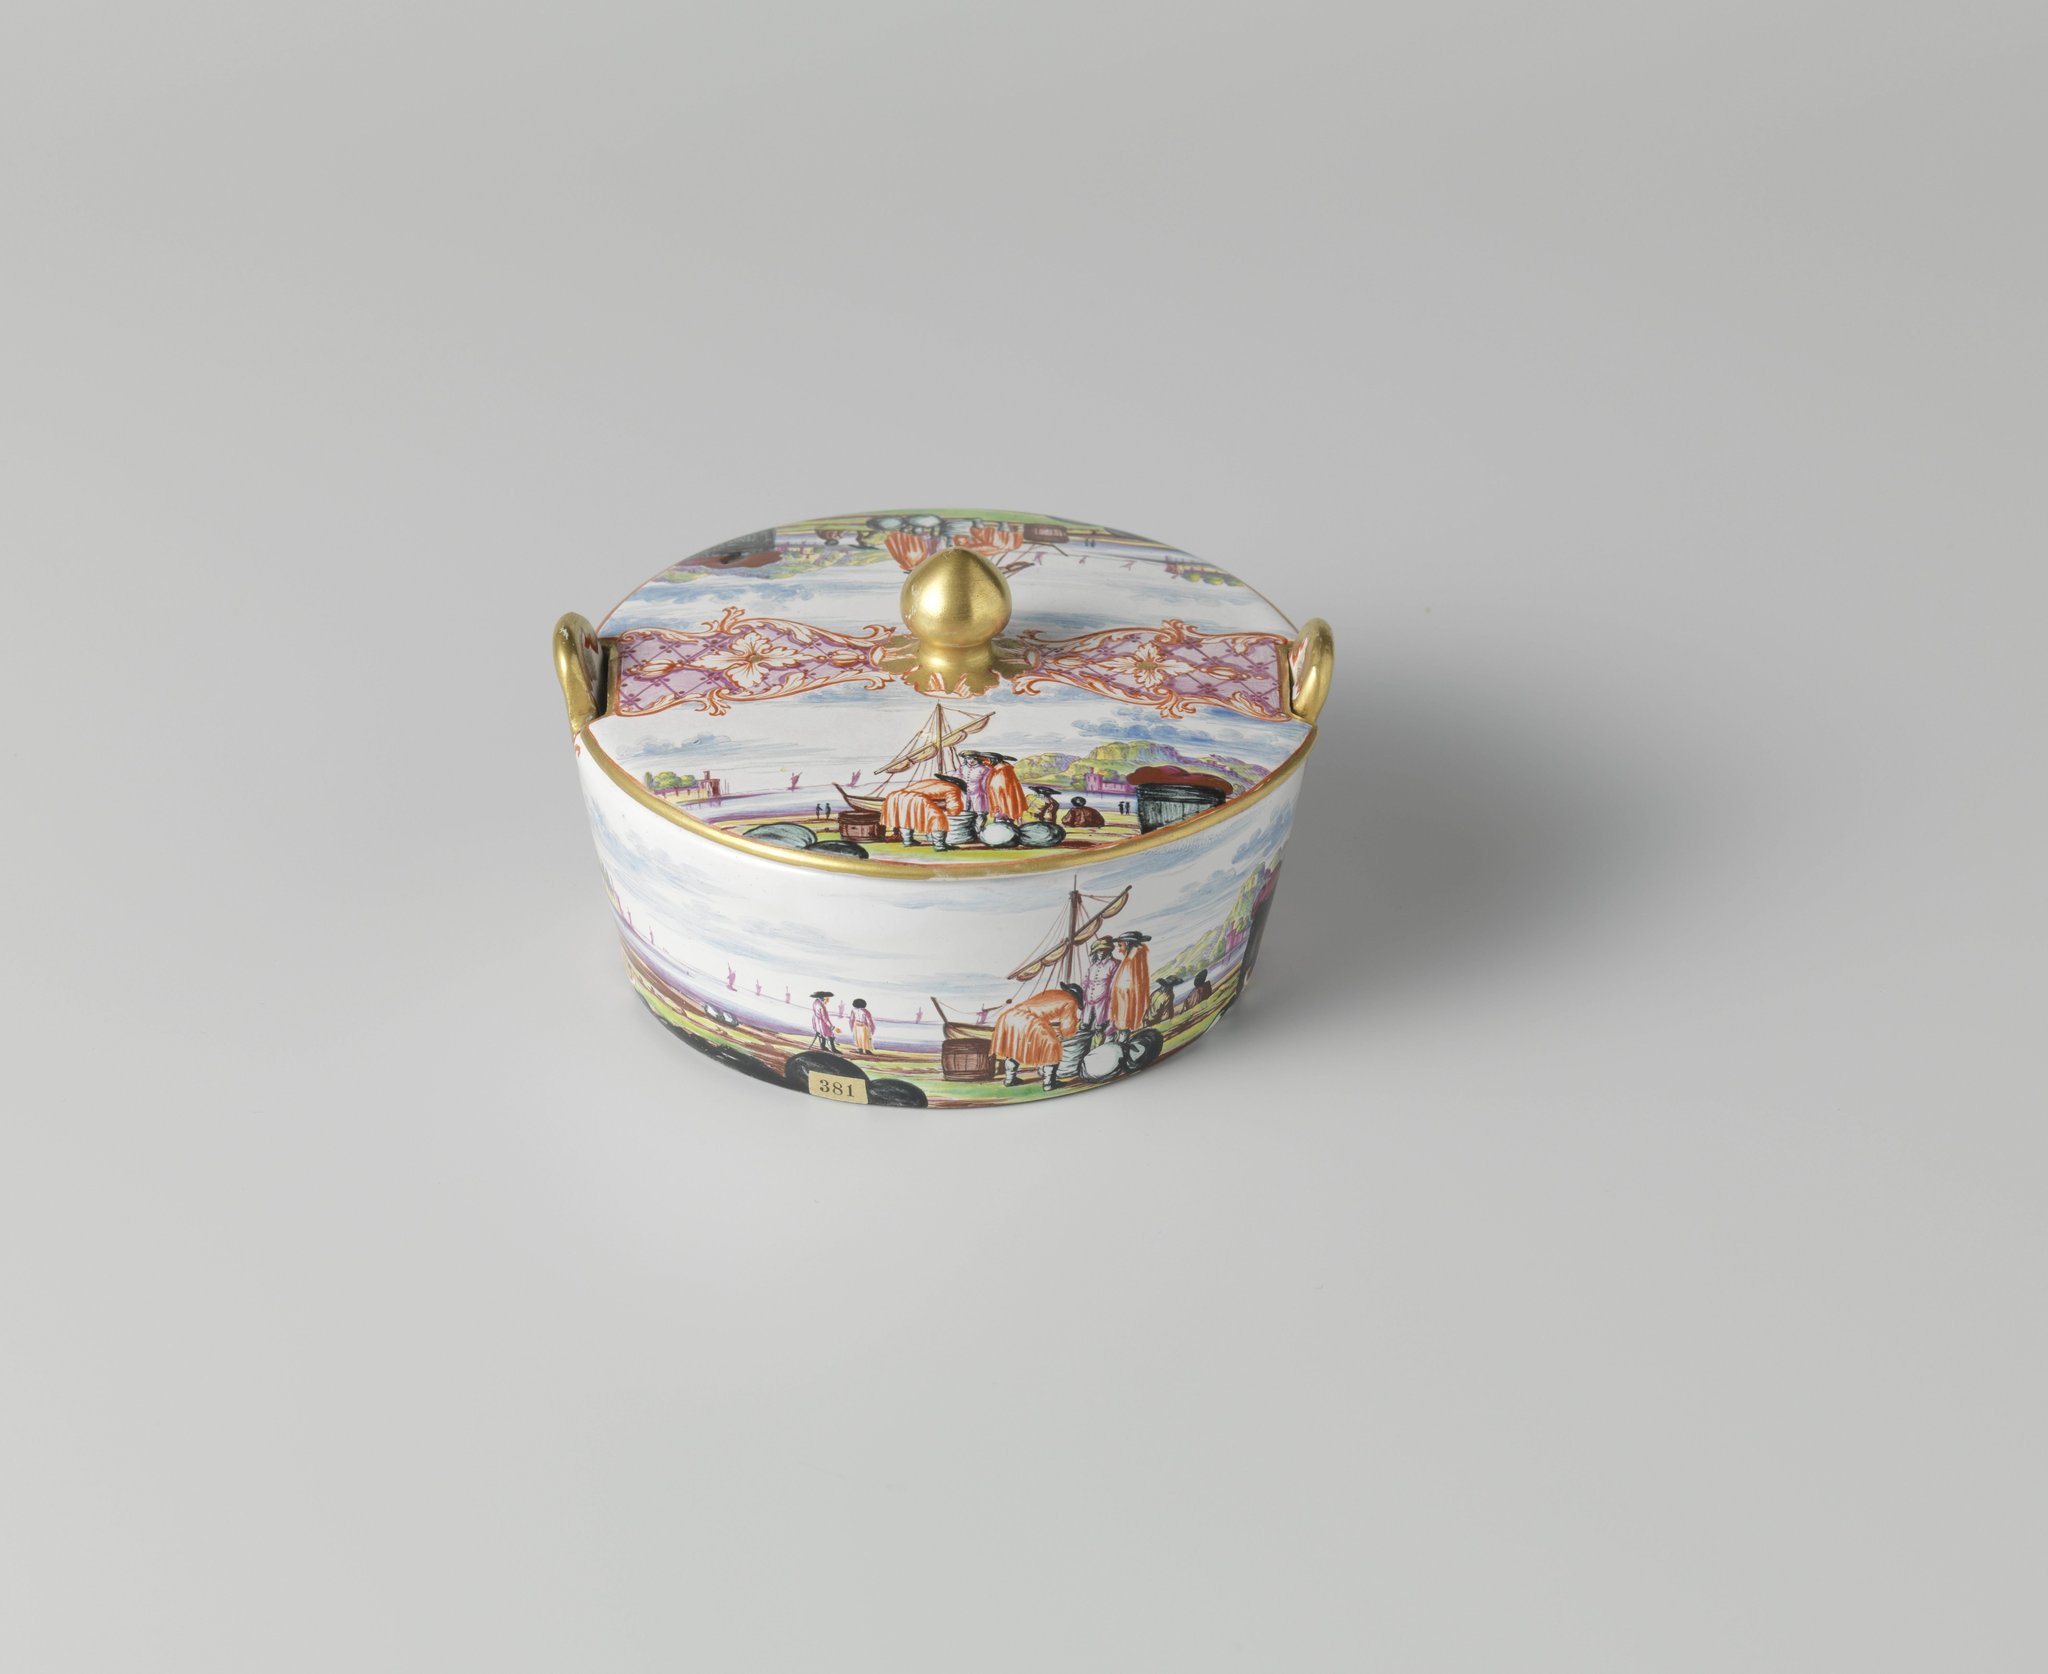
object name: butter dish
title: Deksel van botervloot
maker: Anonymous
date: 1740-1765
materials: faience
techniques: kiln, painted, polychromy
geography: delft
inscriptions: mark: ‘VA’, inscription: ‘10’, inscription: ‘10’, collector's mark: ‘collection J.F. Loudon’, inscription: ‘Goet’